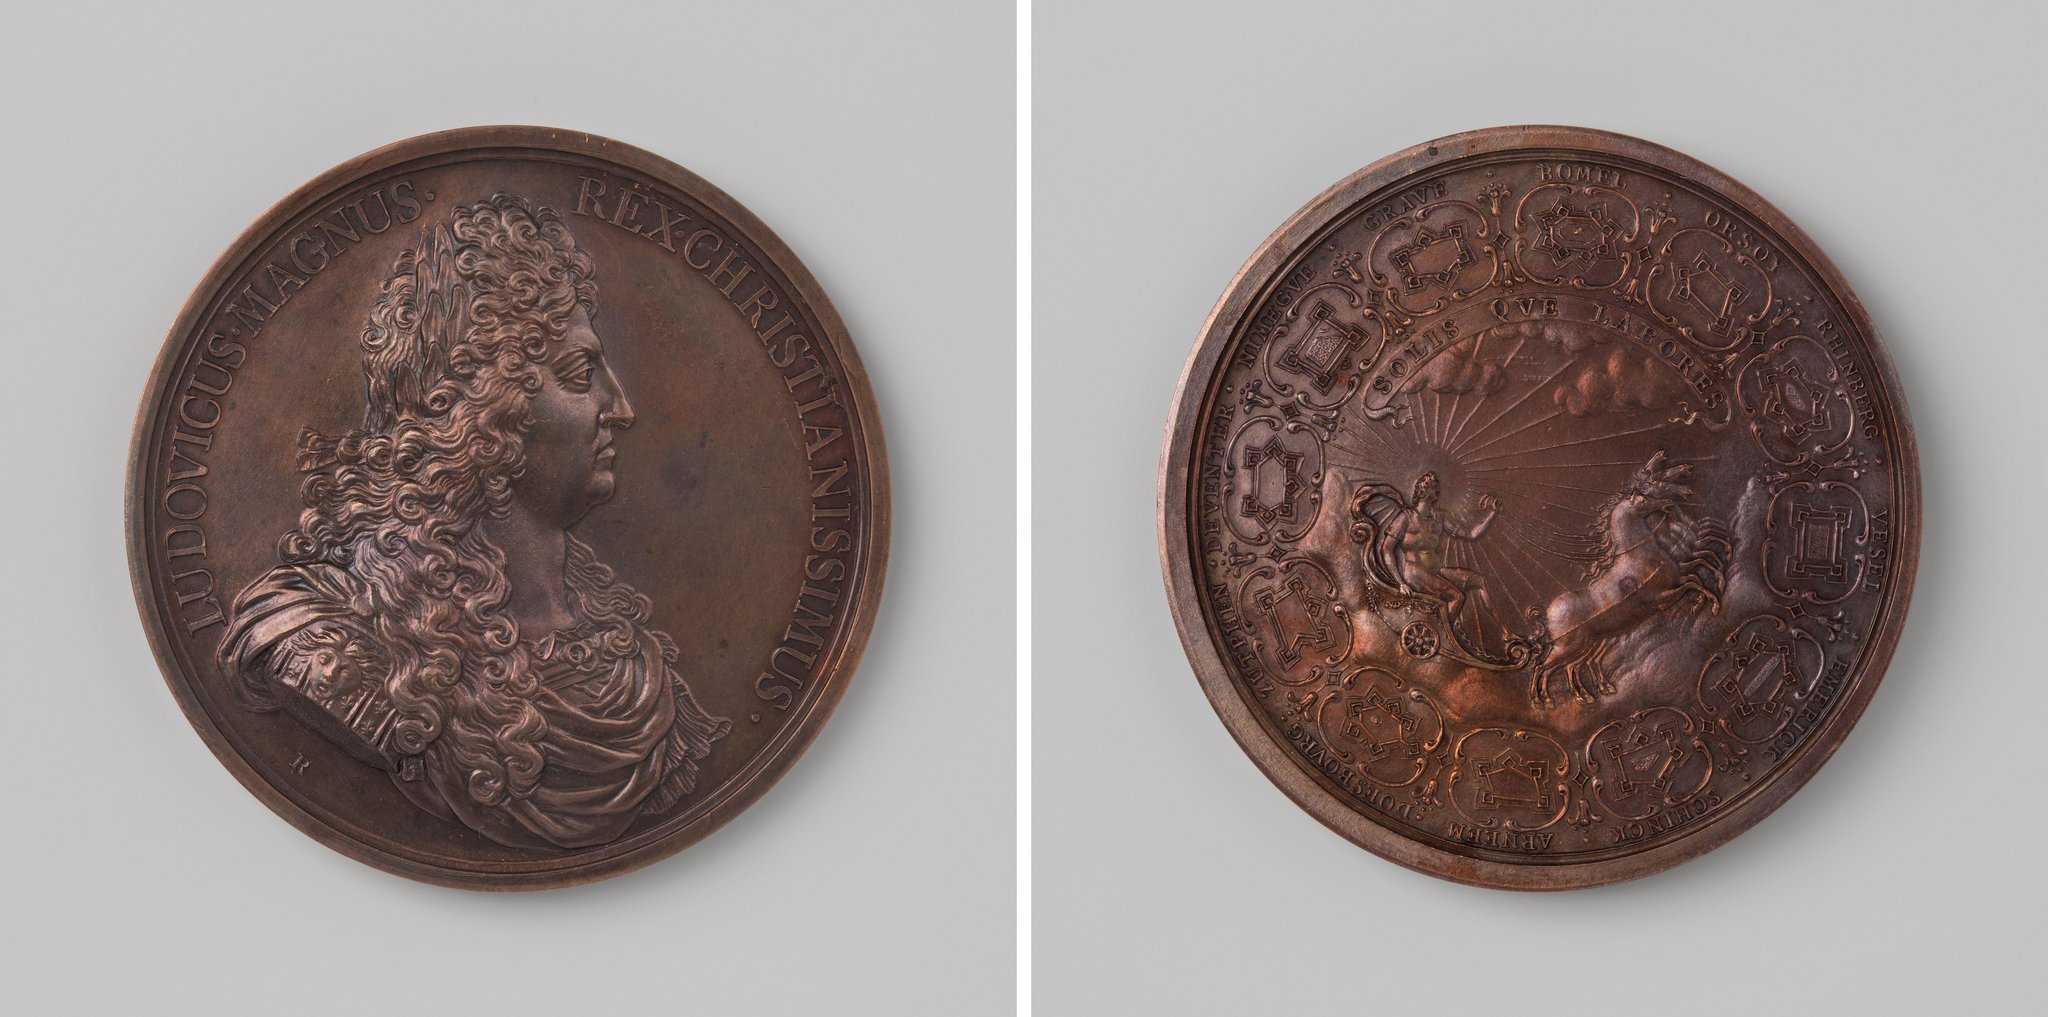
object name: history medal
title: Lodewijk XIV verovert twaalf steden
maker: jérôme roussel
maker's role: medailleur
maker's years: 1663-1713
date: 1686-1713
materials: bronze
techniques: striking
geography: paris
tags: lodewijk xiv (koning van frankrijk), deventer, nijmegen, grave, arnhem, rampjaar (disaster year)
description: Bronzen penning. Voorzijde: borststuk man (Lodewijk XIV) met lauwerkrans binnen omschrift. Keerzijde: koning gezeten in zonnewagen binnen rand met plattegronden van twaalf veroverde, bij naam genoemde steden.